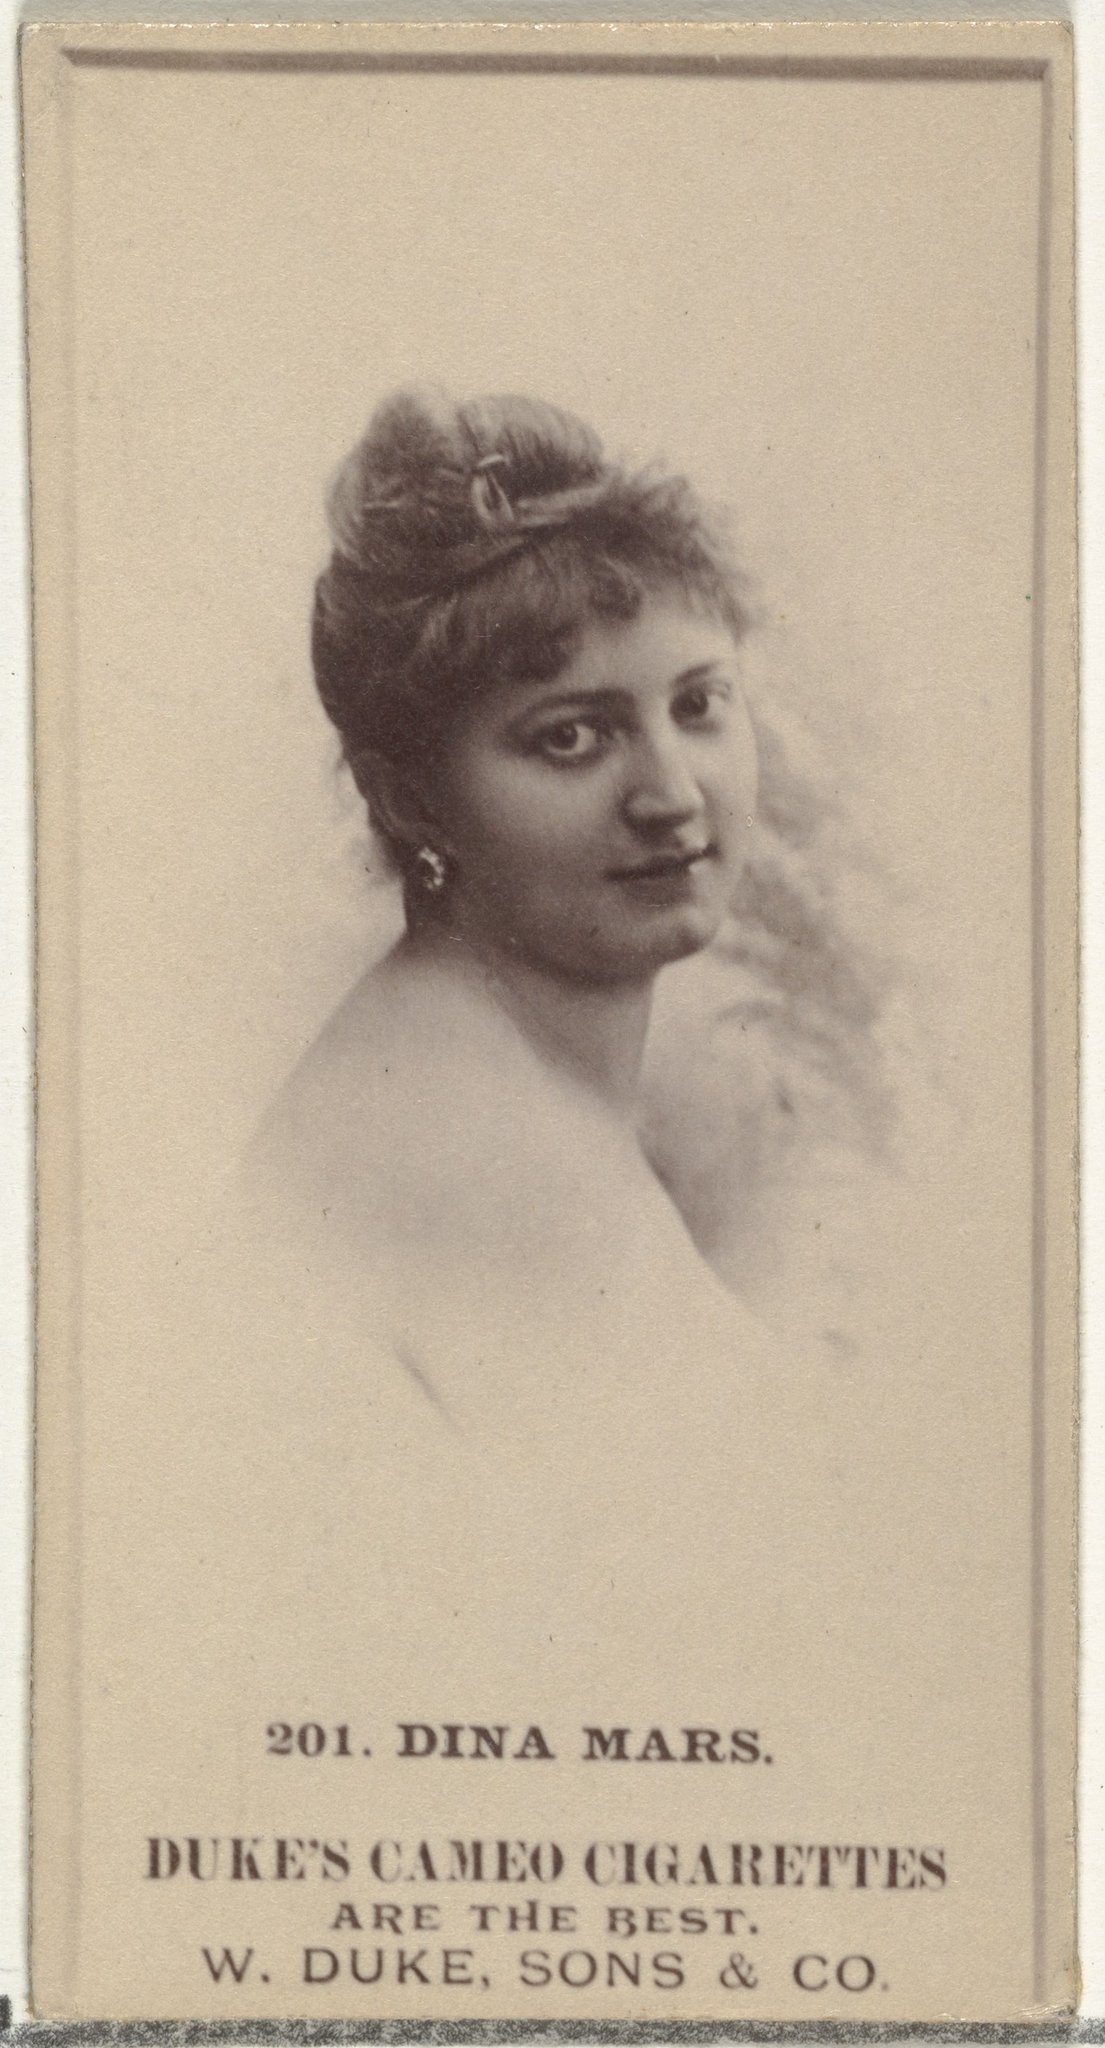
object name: photograph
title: Card Number 201, Dina Mars, from the Actors and Actresses series (N145-5) issued by Duke Sons & Co. to promote Cameo Cigarettes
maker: w. duke, sons & co.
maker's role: publisher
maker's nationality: american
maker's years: 1870-1920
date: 1880-1889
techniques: albumen silver print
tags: portraits,women,actresses